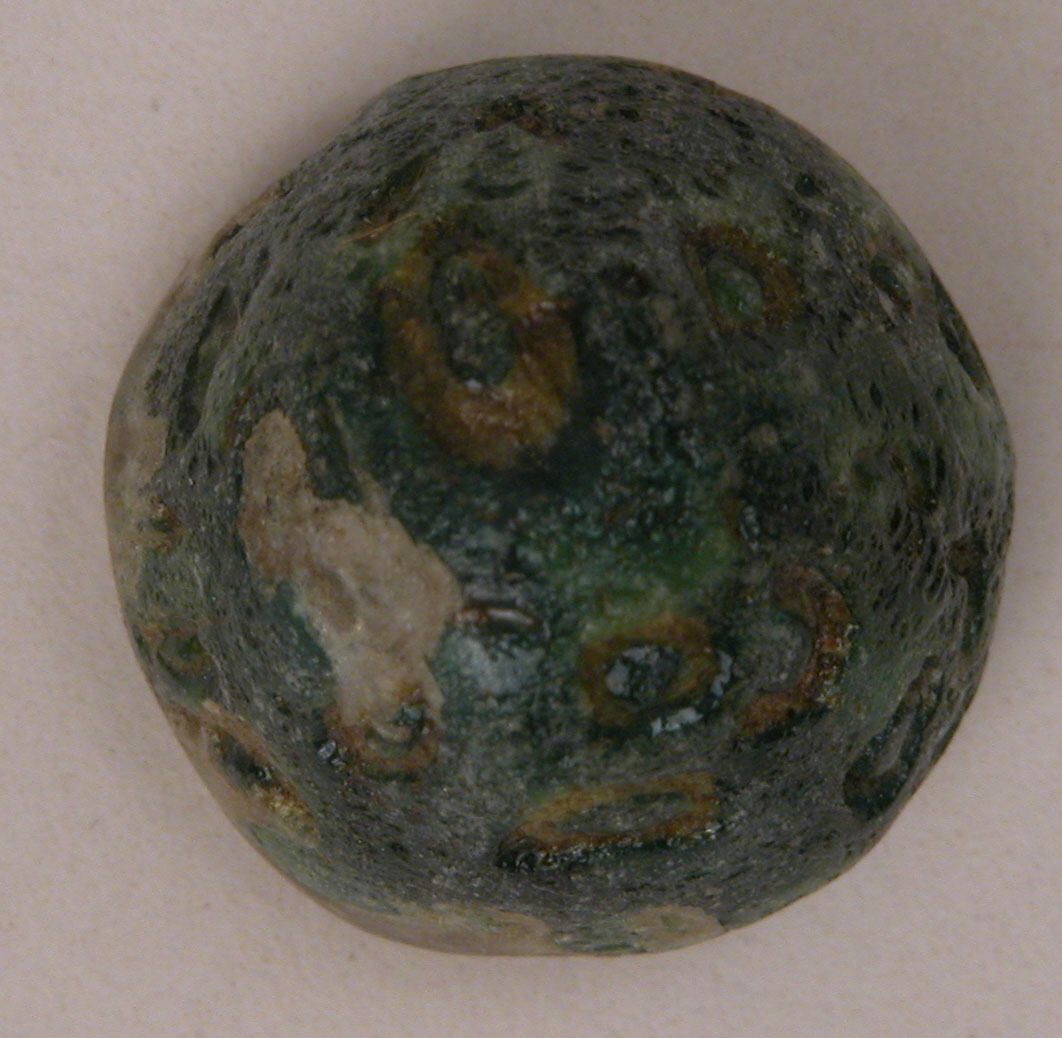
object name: gaming piece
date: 701-1200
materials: glass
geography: islamic lands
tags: games